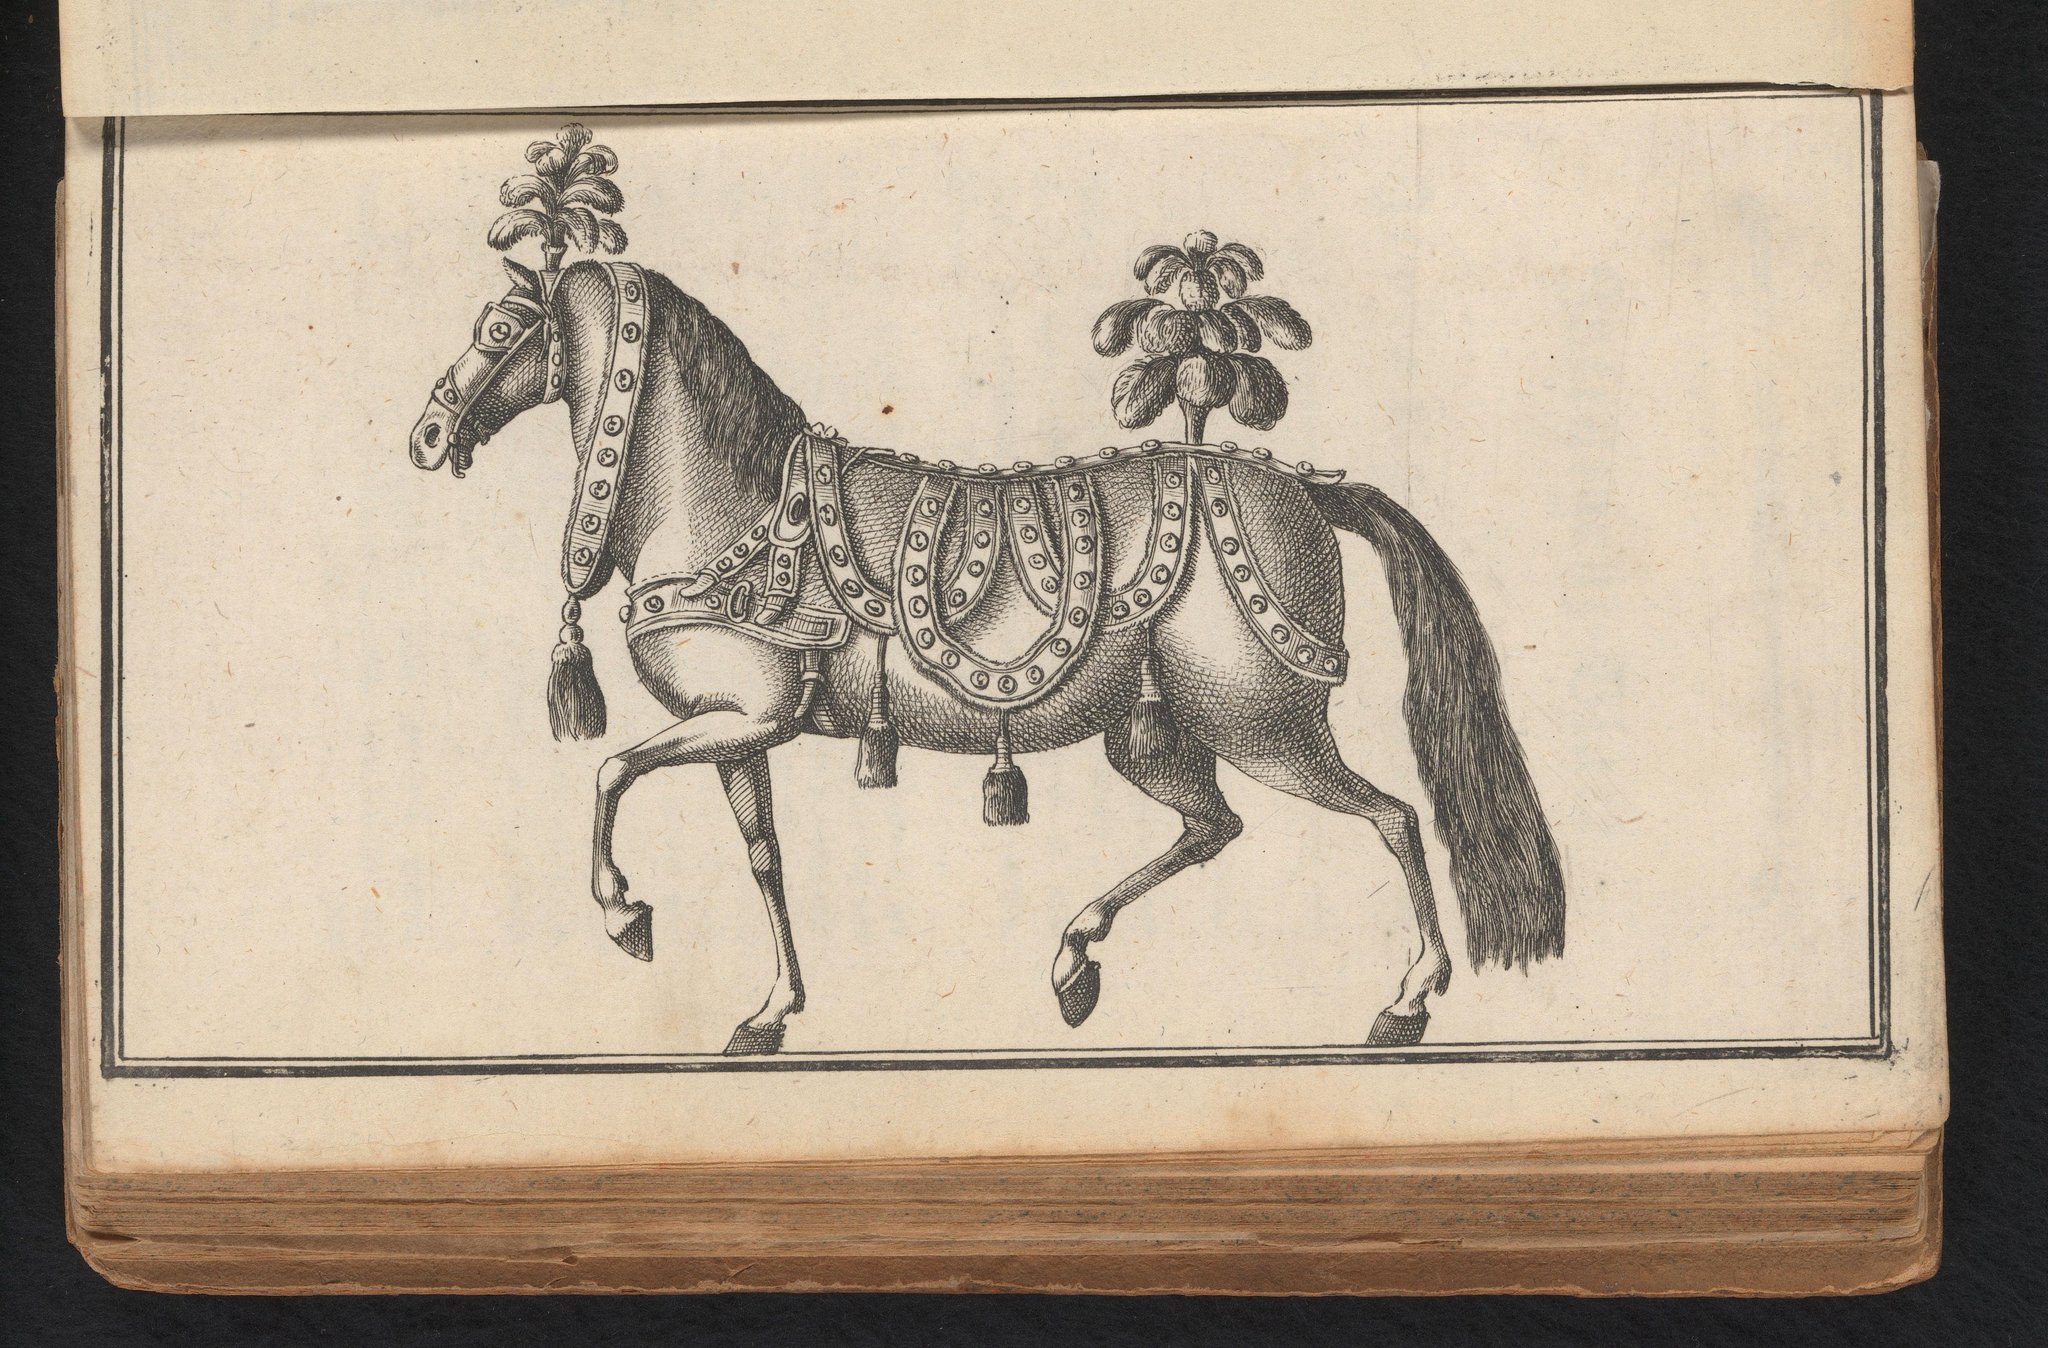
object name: fashion print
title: Journal des Luxus und der Moden 1786, Band I, T. 31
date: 1786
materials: paper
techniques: etching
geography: weimar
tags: fashion plates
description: Prent uit het modetijdschrift Journal des Luxus und der Moden, uitgegeven door Friedrich Justin Bertuch en Georg Melchior Kraus, Weimar, 1786-1826.